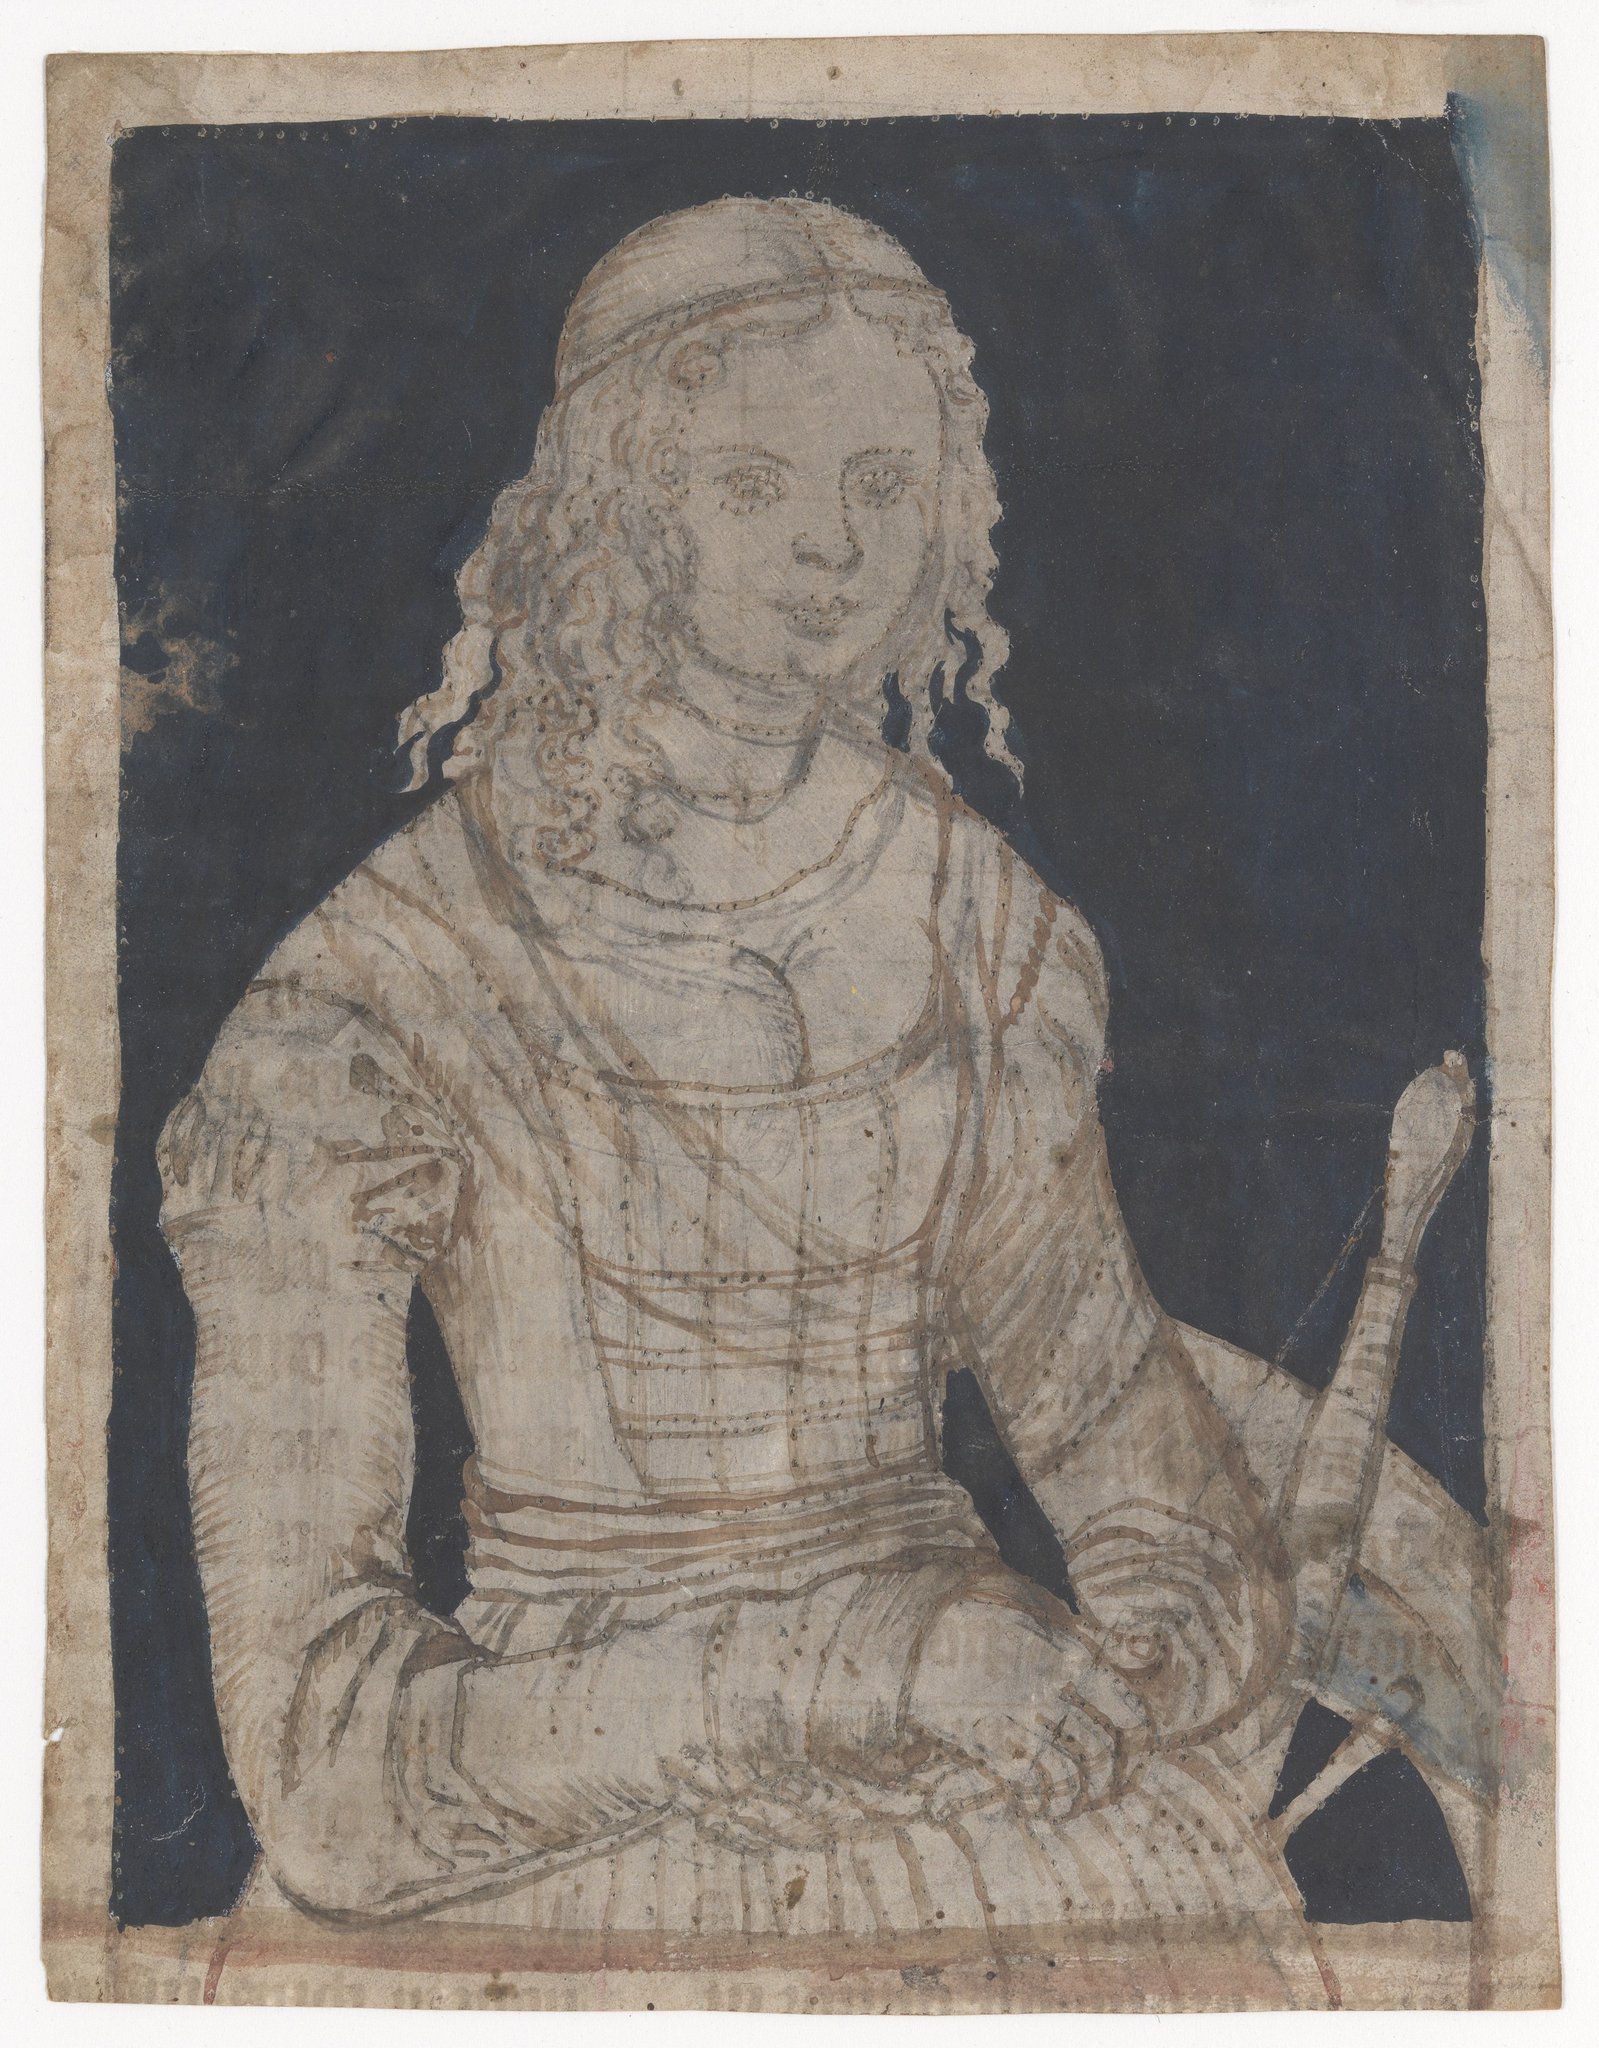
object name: drawing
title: Saint Catherine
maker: lucas cranach the elder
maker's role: artist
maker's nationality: german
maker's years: 1472-1553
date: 1467-1566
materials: ink, parchment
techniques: brush, transfer, wash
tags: portraits,saint catherine